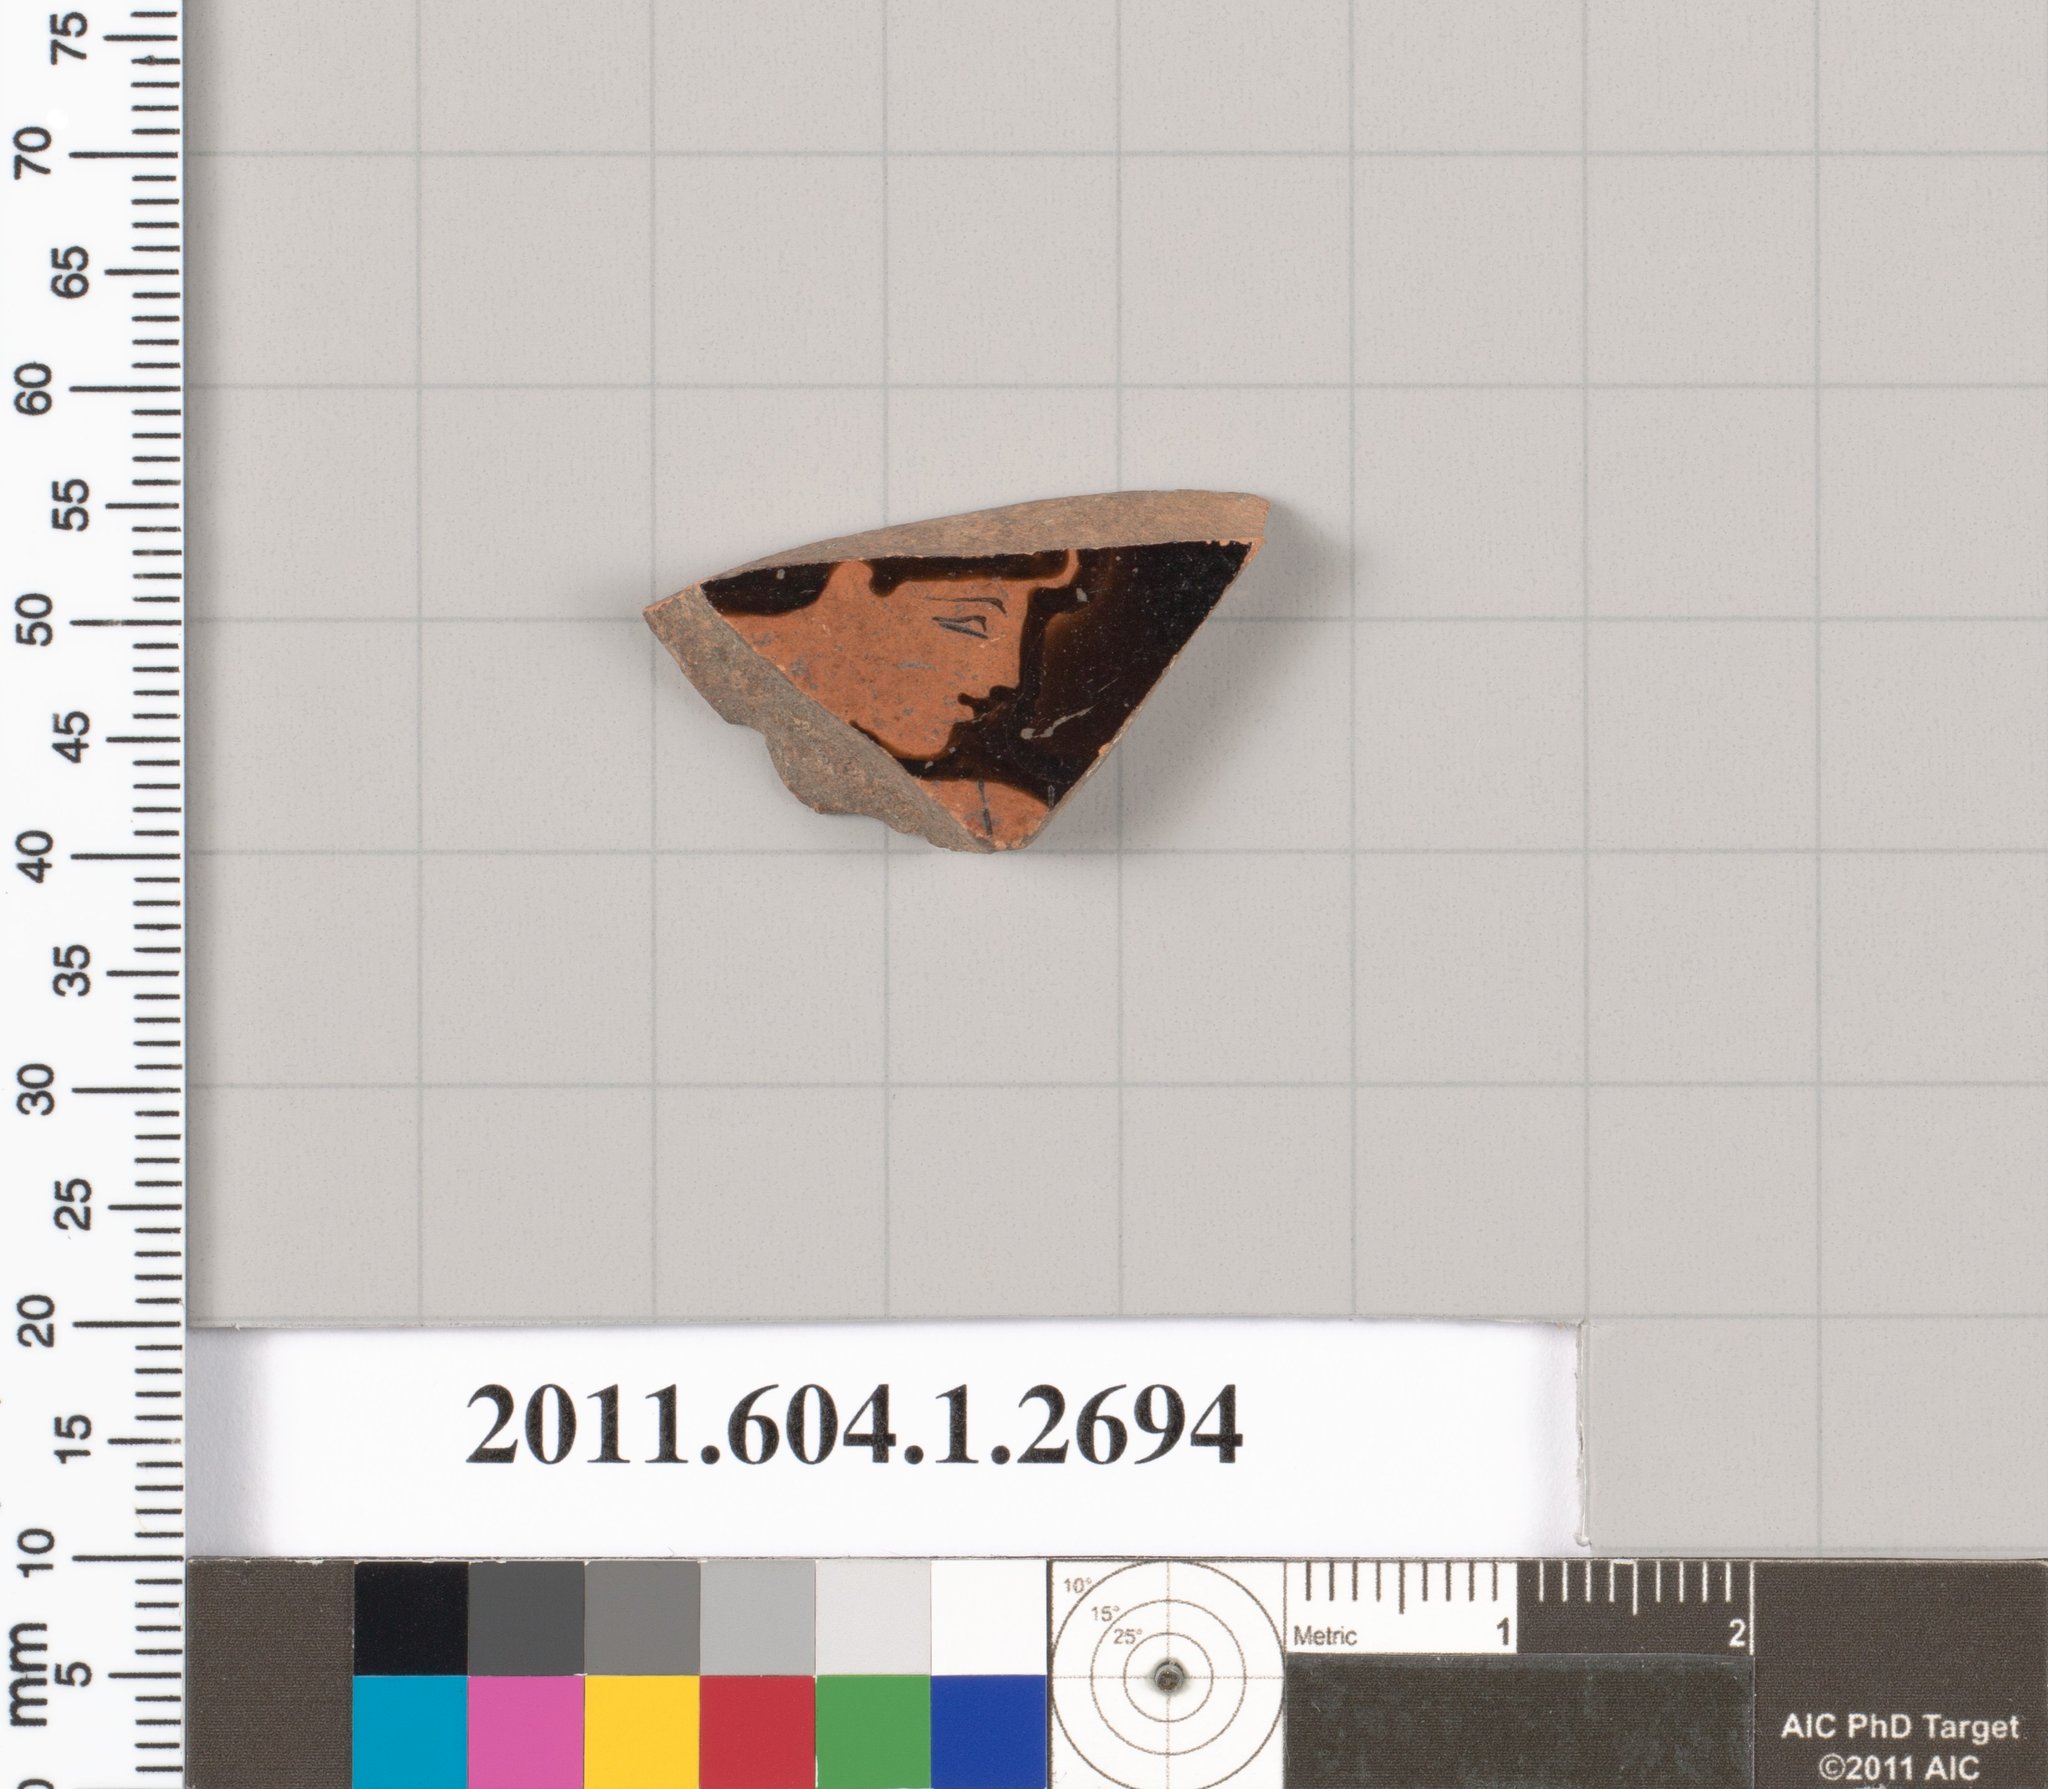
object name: kylix fragment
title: Terracotta fragment of a kylix (drinking cup)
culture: greek, attic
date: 475-451 BCE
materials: terracotta